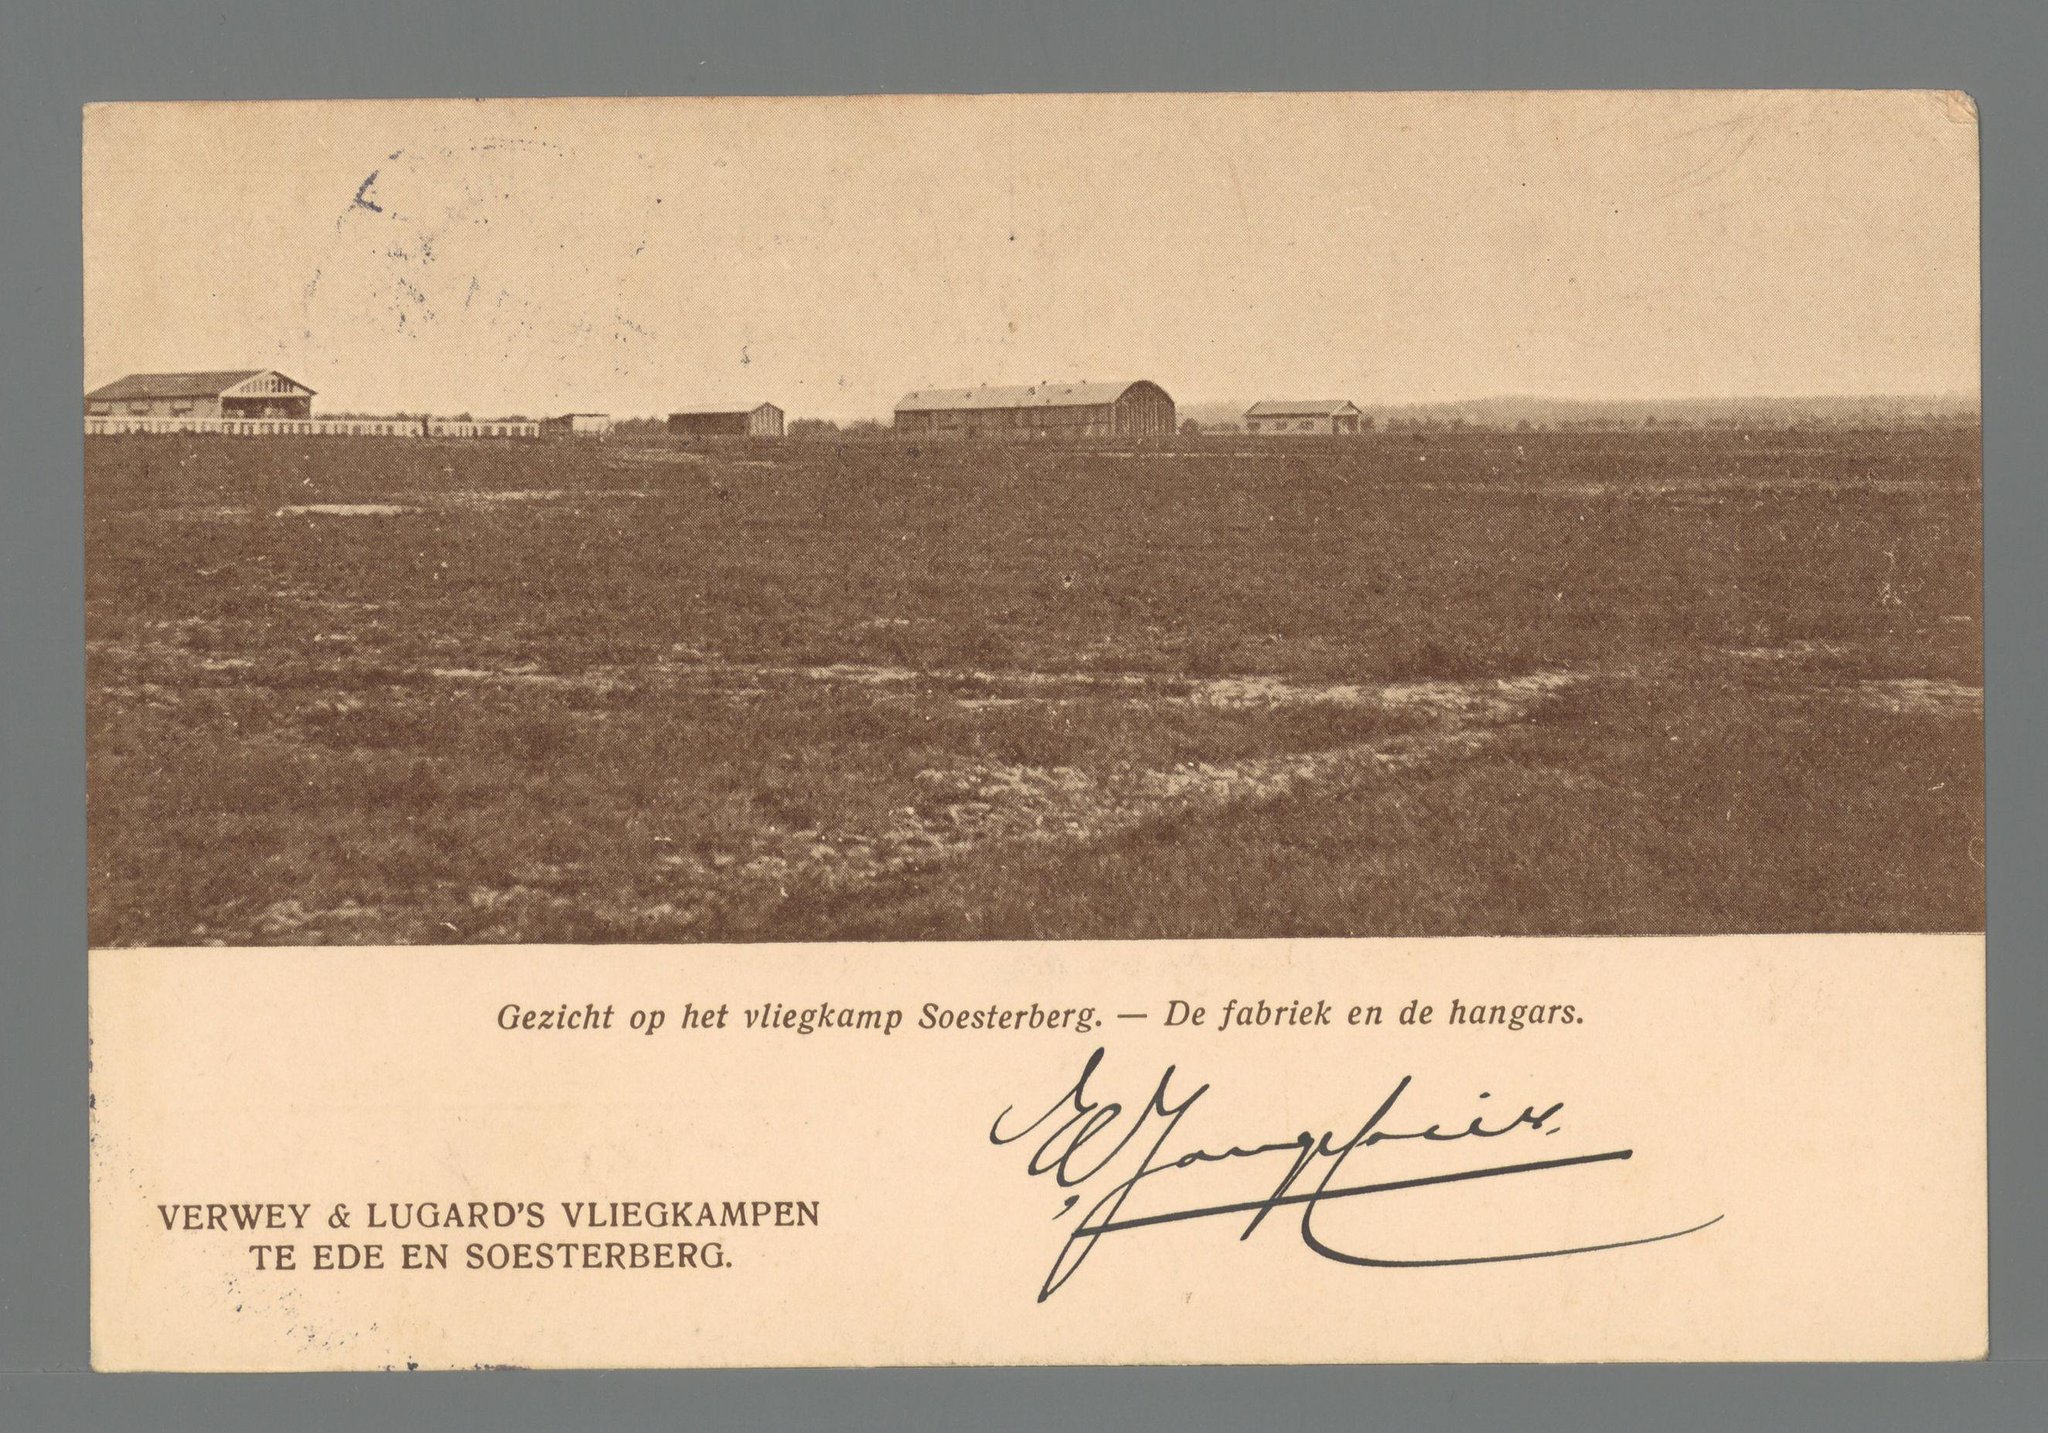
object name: photomechanical print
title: Gezicht op het vliegkamp Soesterberg. - De fabriek en de hangars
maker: Anonymous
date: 1905-1911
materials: cardboard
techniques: writing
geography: soesterberg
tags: factory-building, airfield, airport, hangar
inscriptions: postage stamp